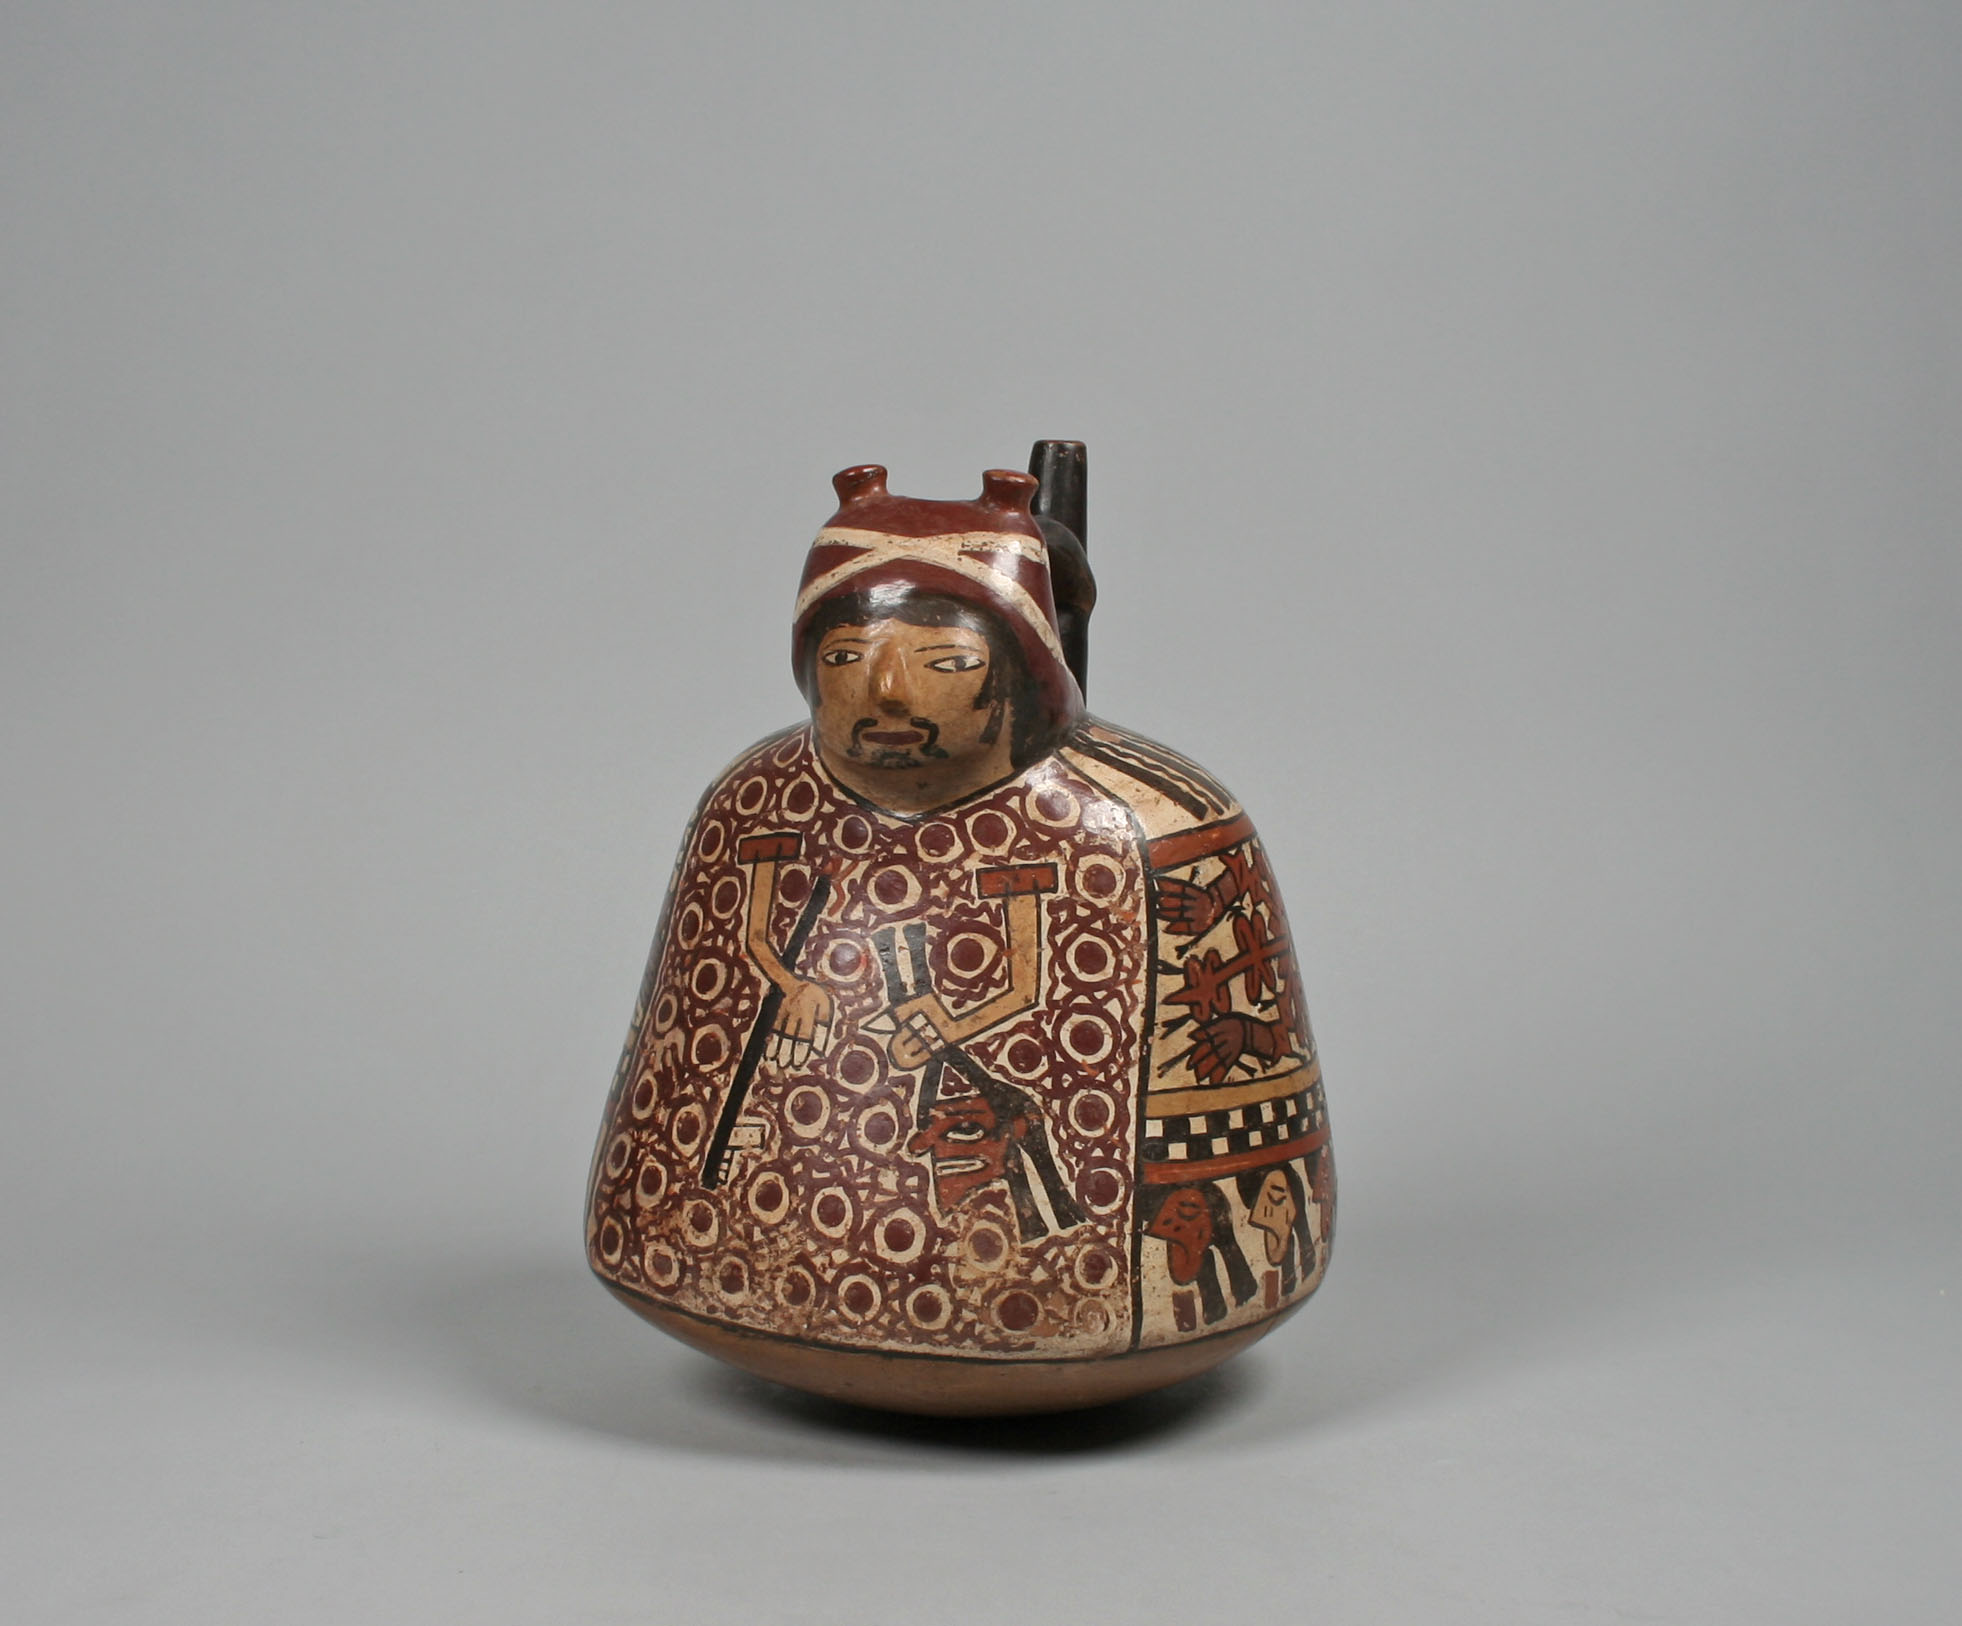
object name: bottle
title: Spout-and-bridge bottle with warrior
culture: nasca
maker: nasca artist(s)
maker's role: artist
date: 400-600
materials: ceramic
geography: peru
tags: men